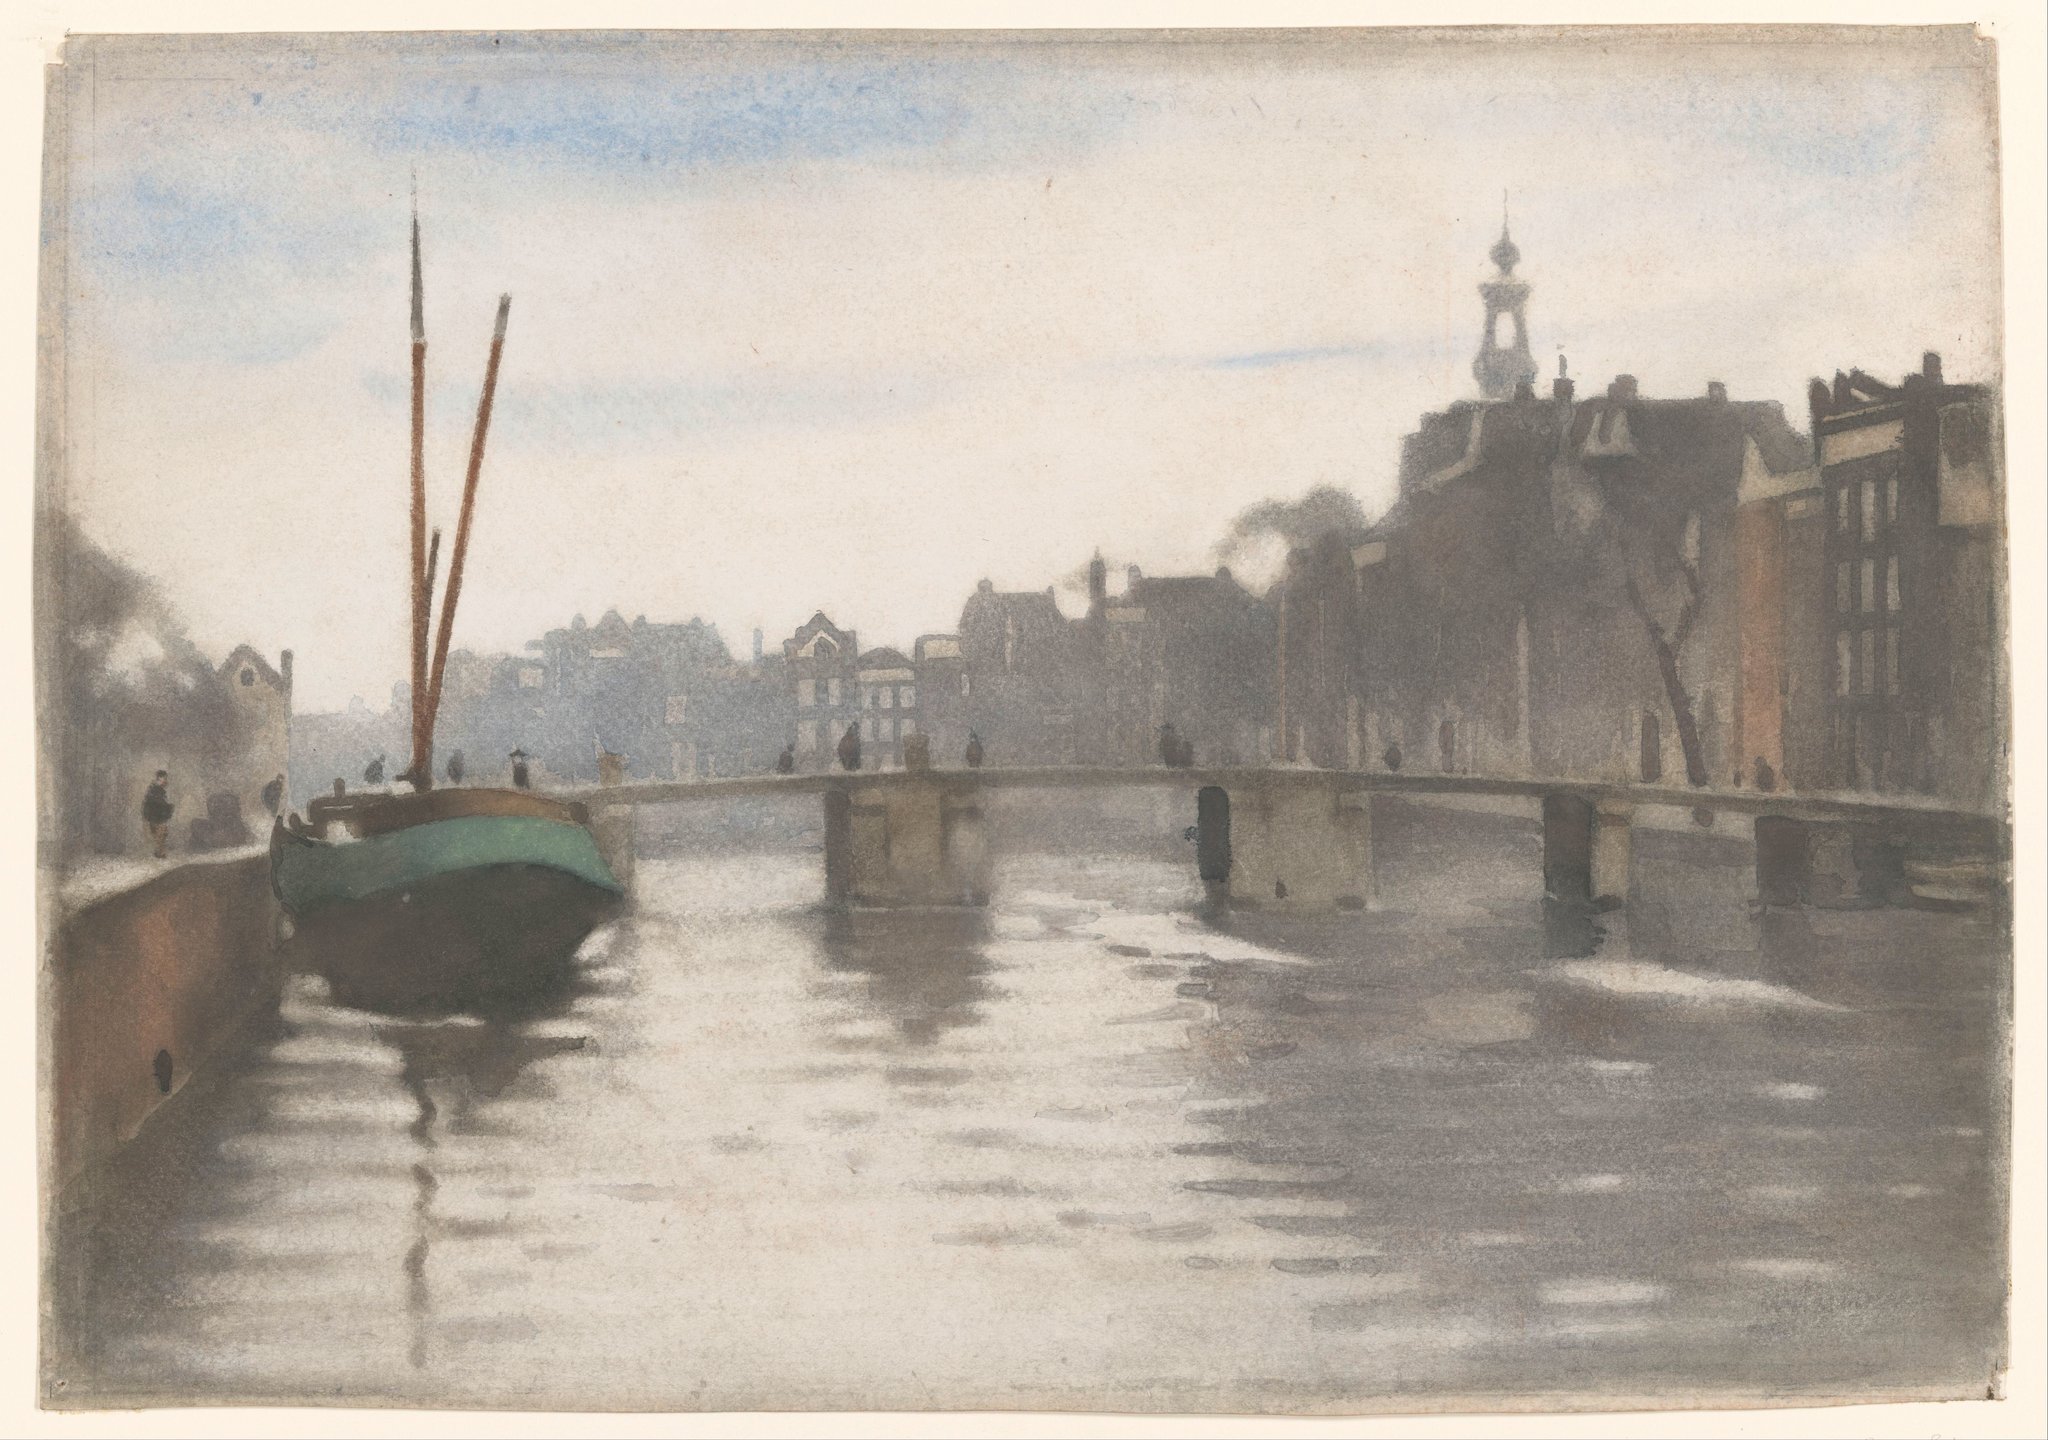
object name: watercolor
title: Oude Schans te Amsterdam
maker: willem witsen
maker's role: draughtsman, painter, print maker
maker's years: 1860-1923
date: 1870-1923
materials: paper, watercolor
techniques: brush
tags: bridge in city across river, canal, etc.